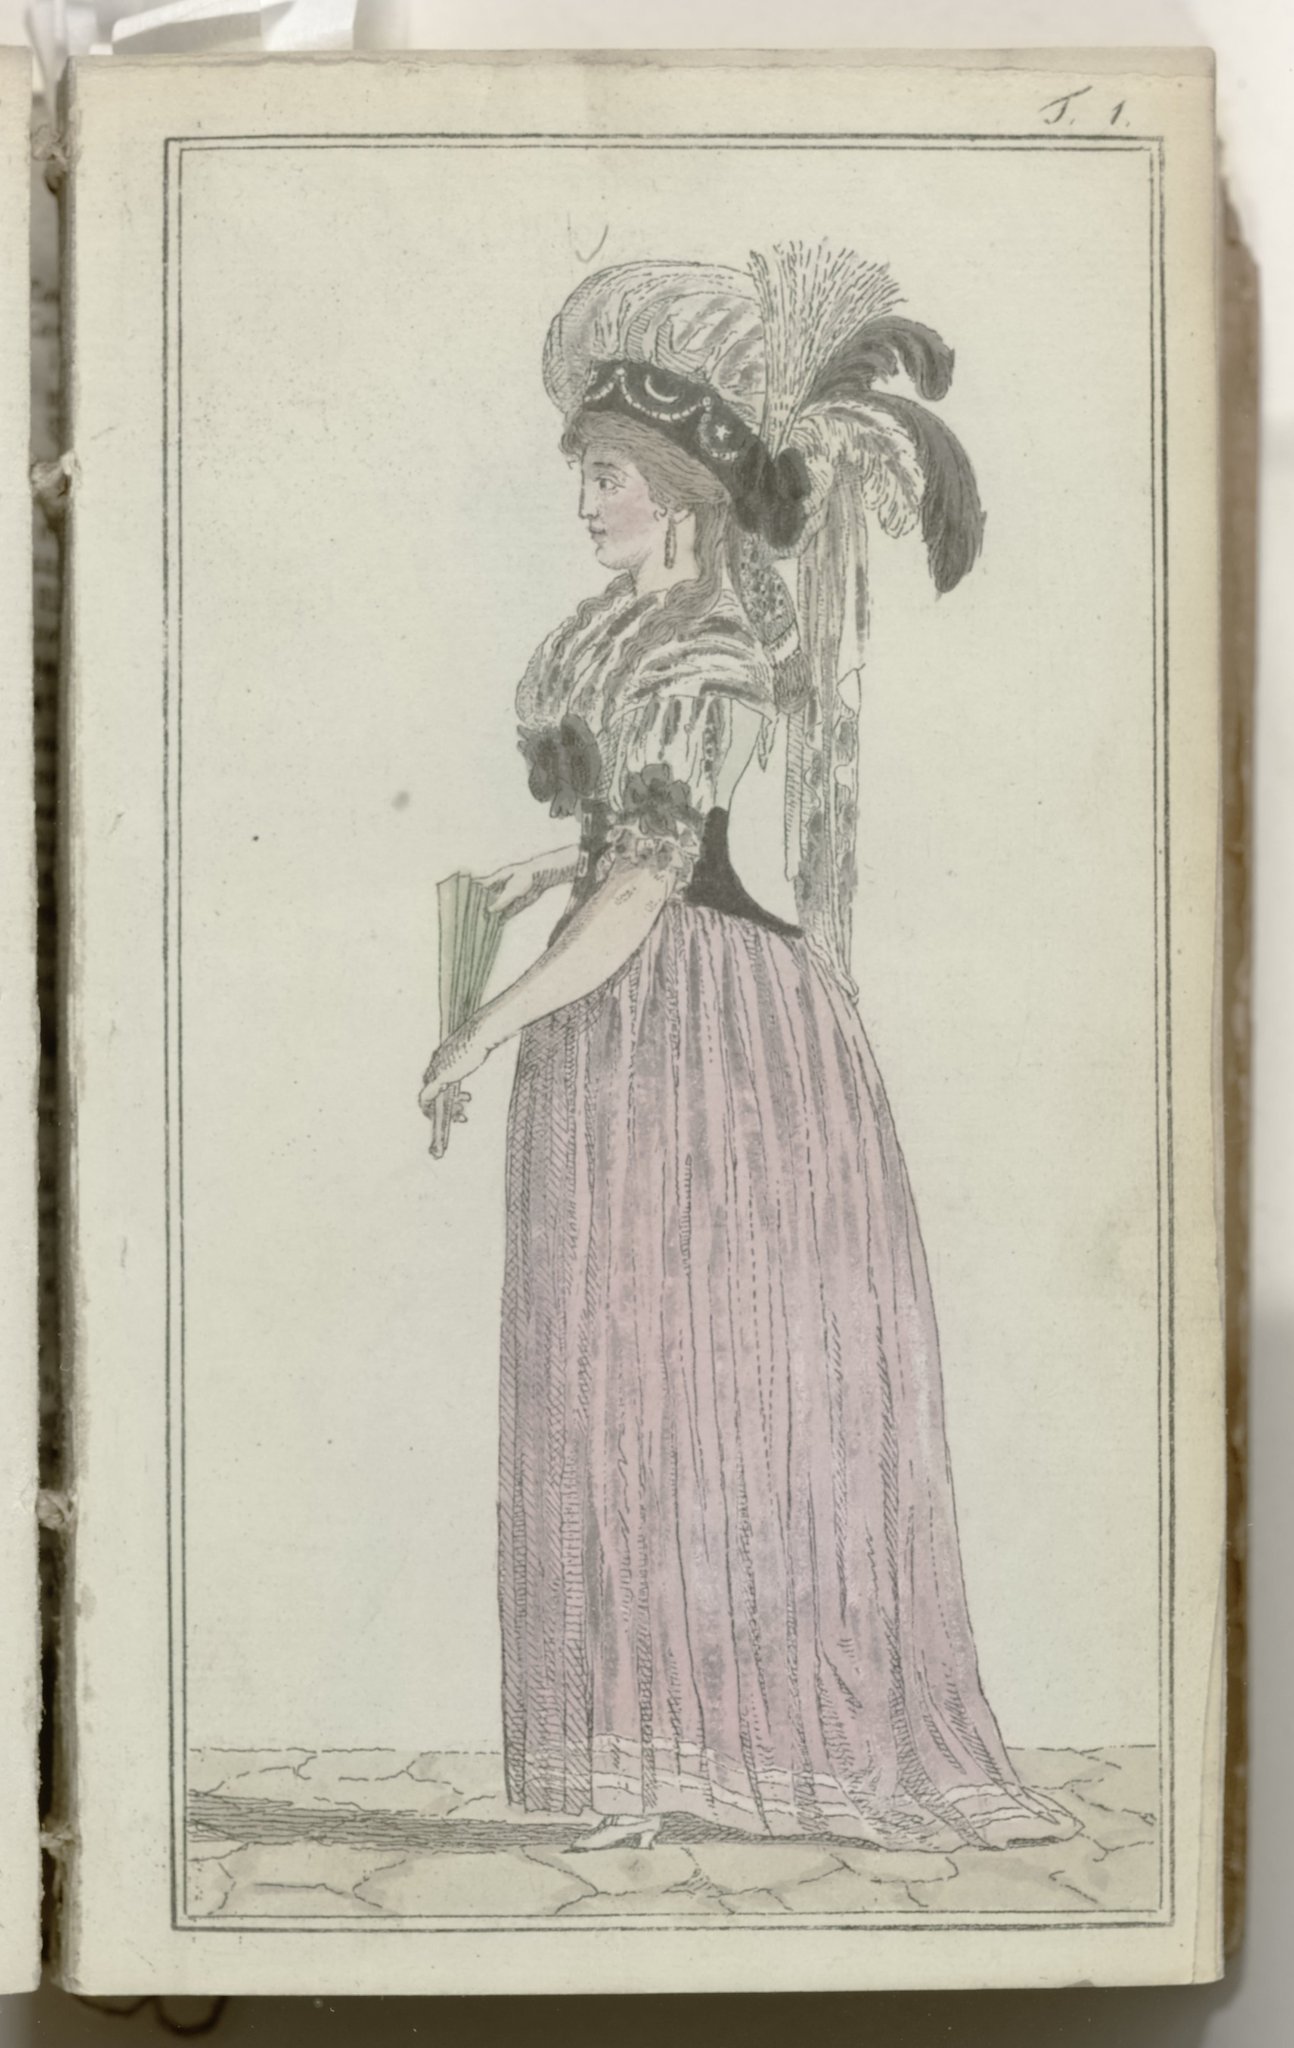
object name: fashion print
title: Journal des Luxus und der Moden 1788, Band III, T.1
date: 1788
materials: paper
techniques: etching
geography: weimar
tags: fashion plates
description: Elegante vrouw uit Rome, in een japon waarmee zij 's avonds op de Corso verschijnt of naar het theater gaat. Fichu met strik op de borst. Corselet met gespen om het middel. Op het hoofd een Turkse tulband, versierd met parels, veren, een aigrette en een sluier. Prent uit het modetijdschrift Journal des Luxus und der Moden, uitgegeven door Friedrich Justin Bertuch en Georg Melchior Kraus, Weimar, 1786-1826.